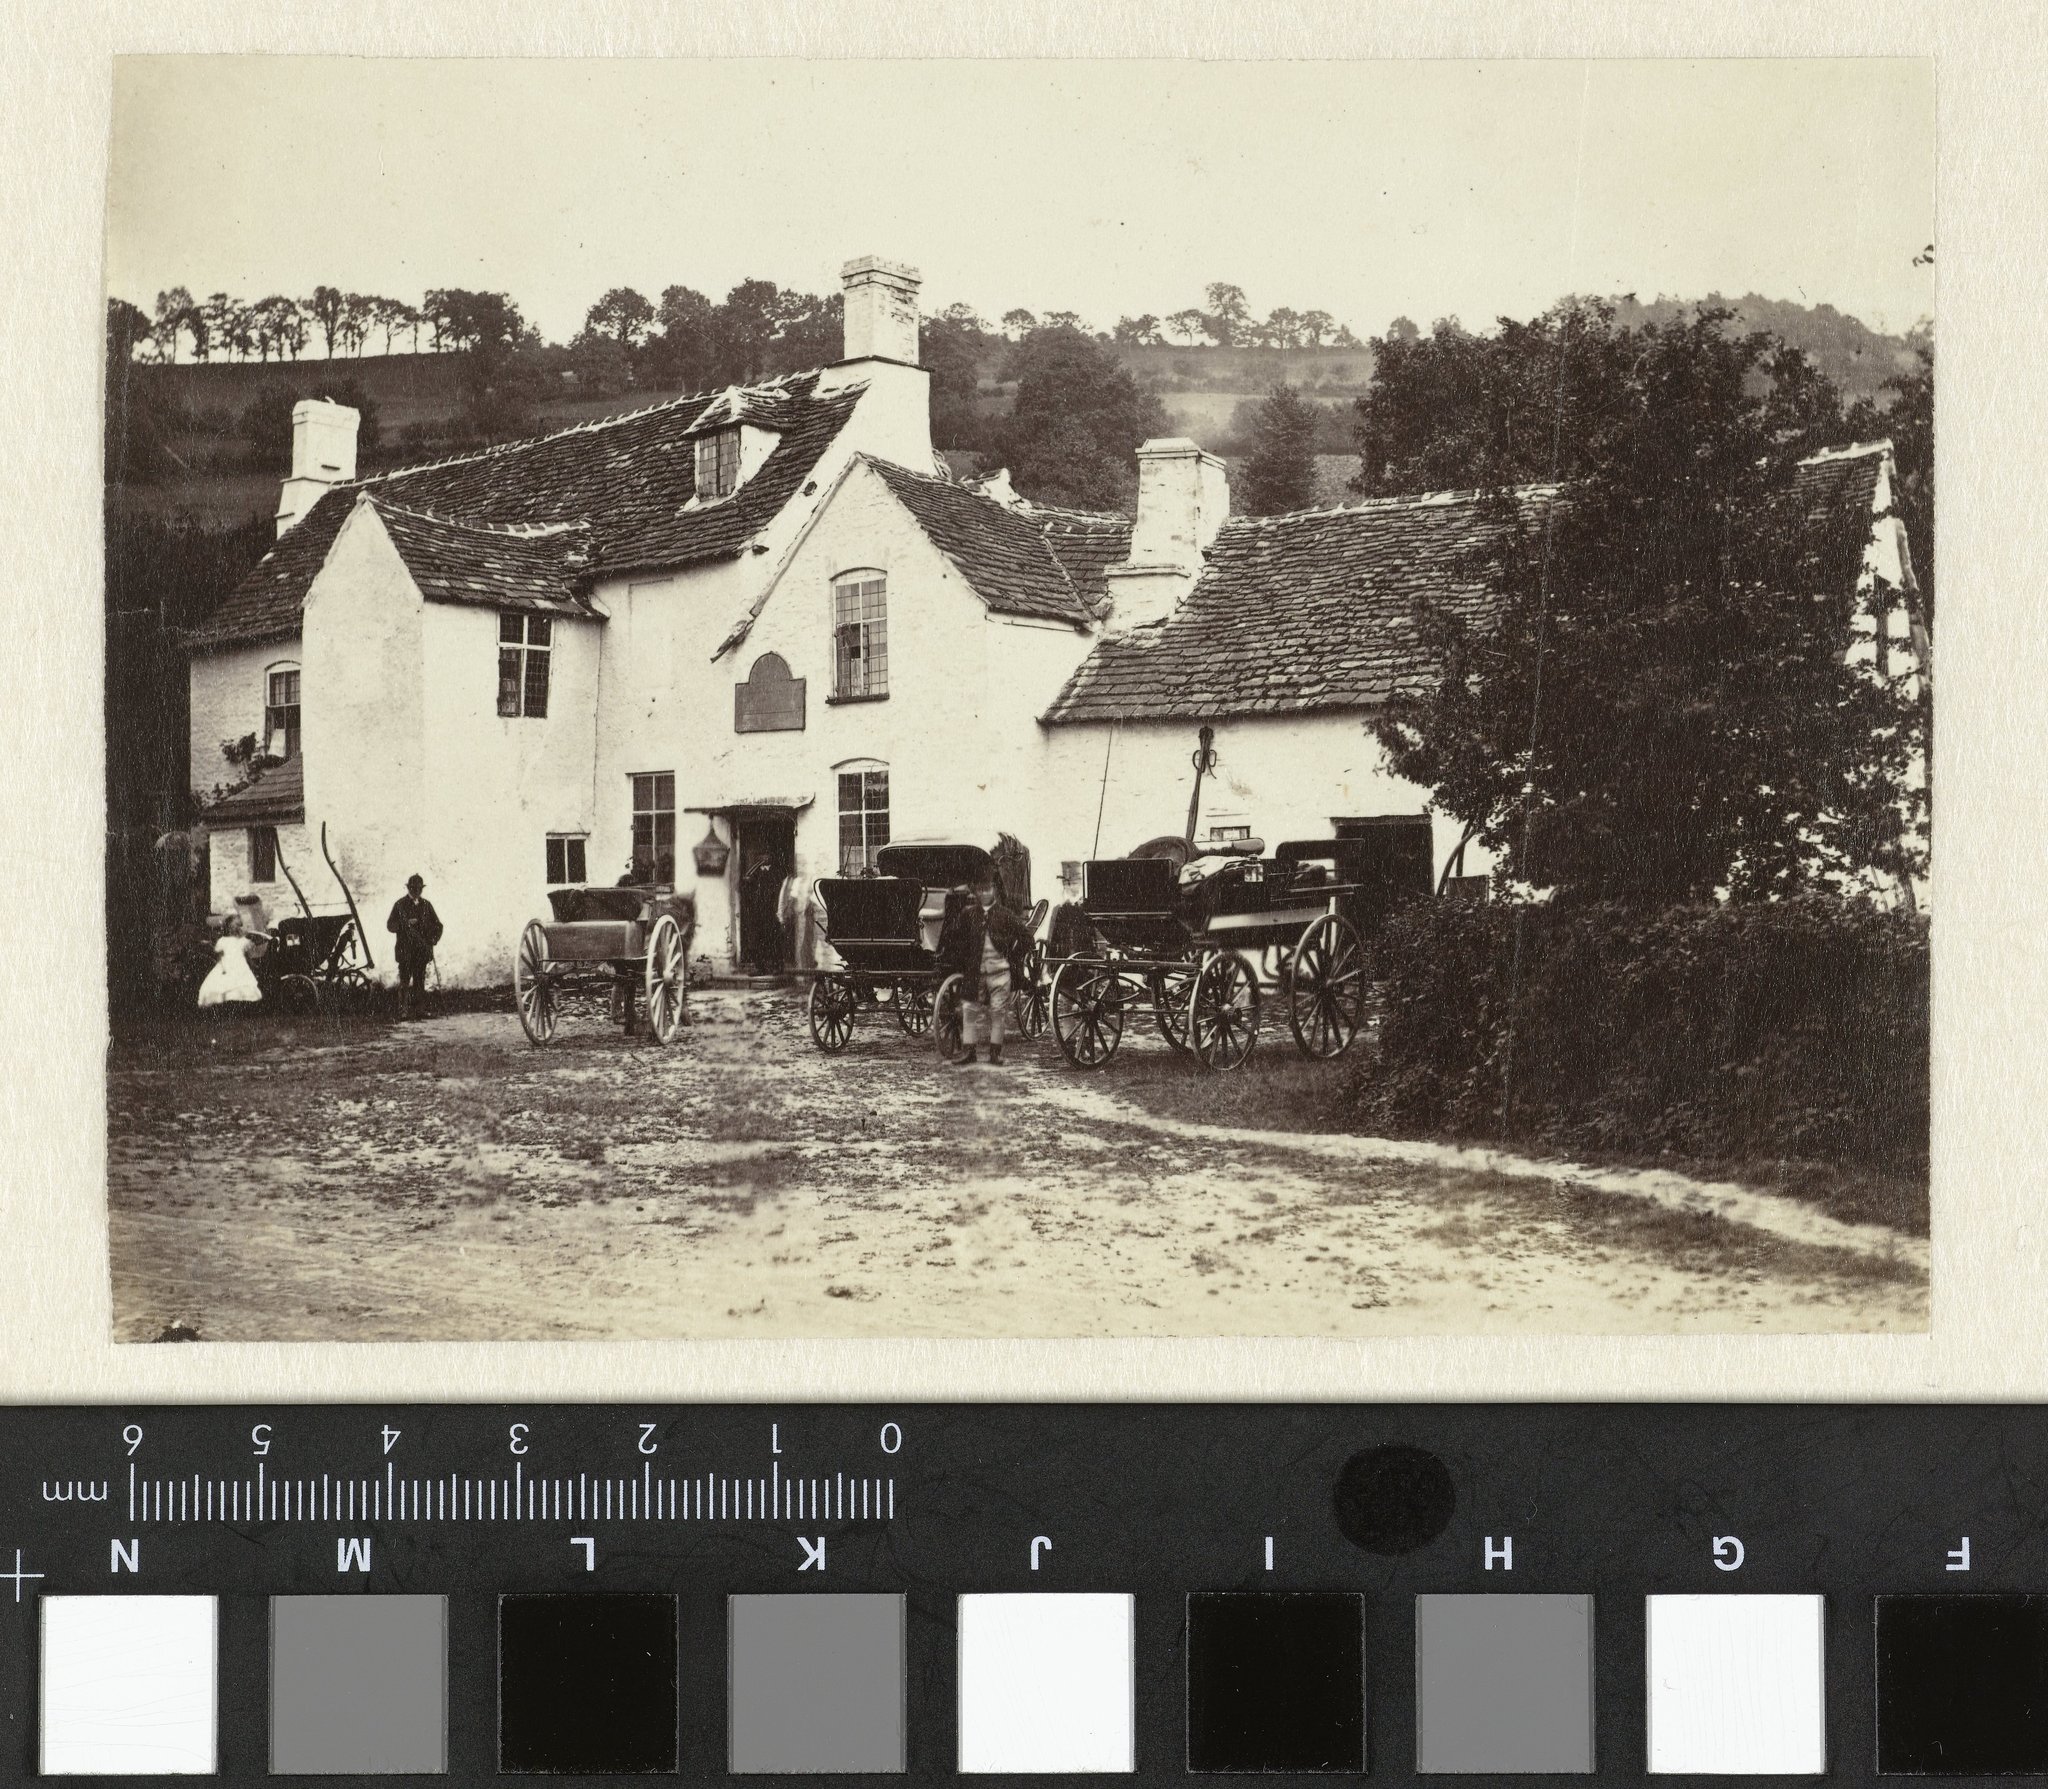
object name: photograph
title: Herberg met koetsen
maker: Anonymous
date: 1851-1890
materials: paper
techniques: albumen print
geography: great britain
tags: four-wheeled, animal-drawn vehicle, e.g.: cab, carriage, coach, hotel, hostelry, inn, great britain